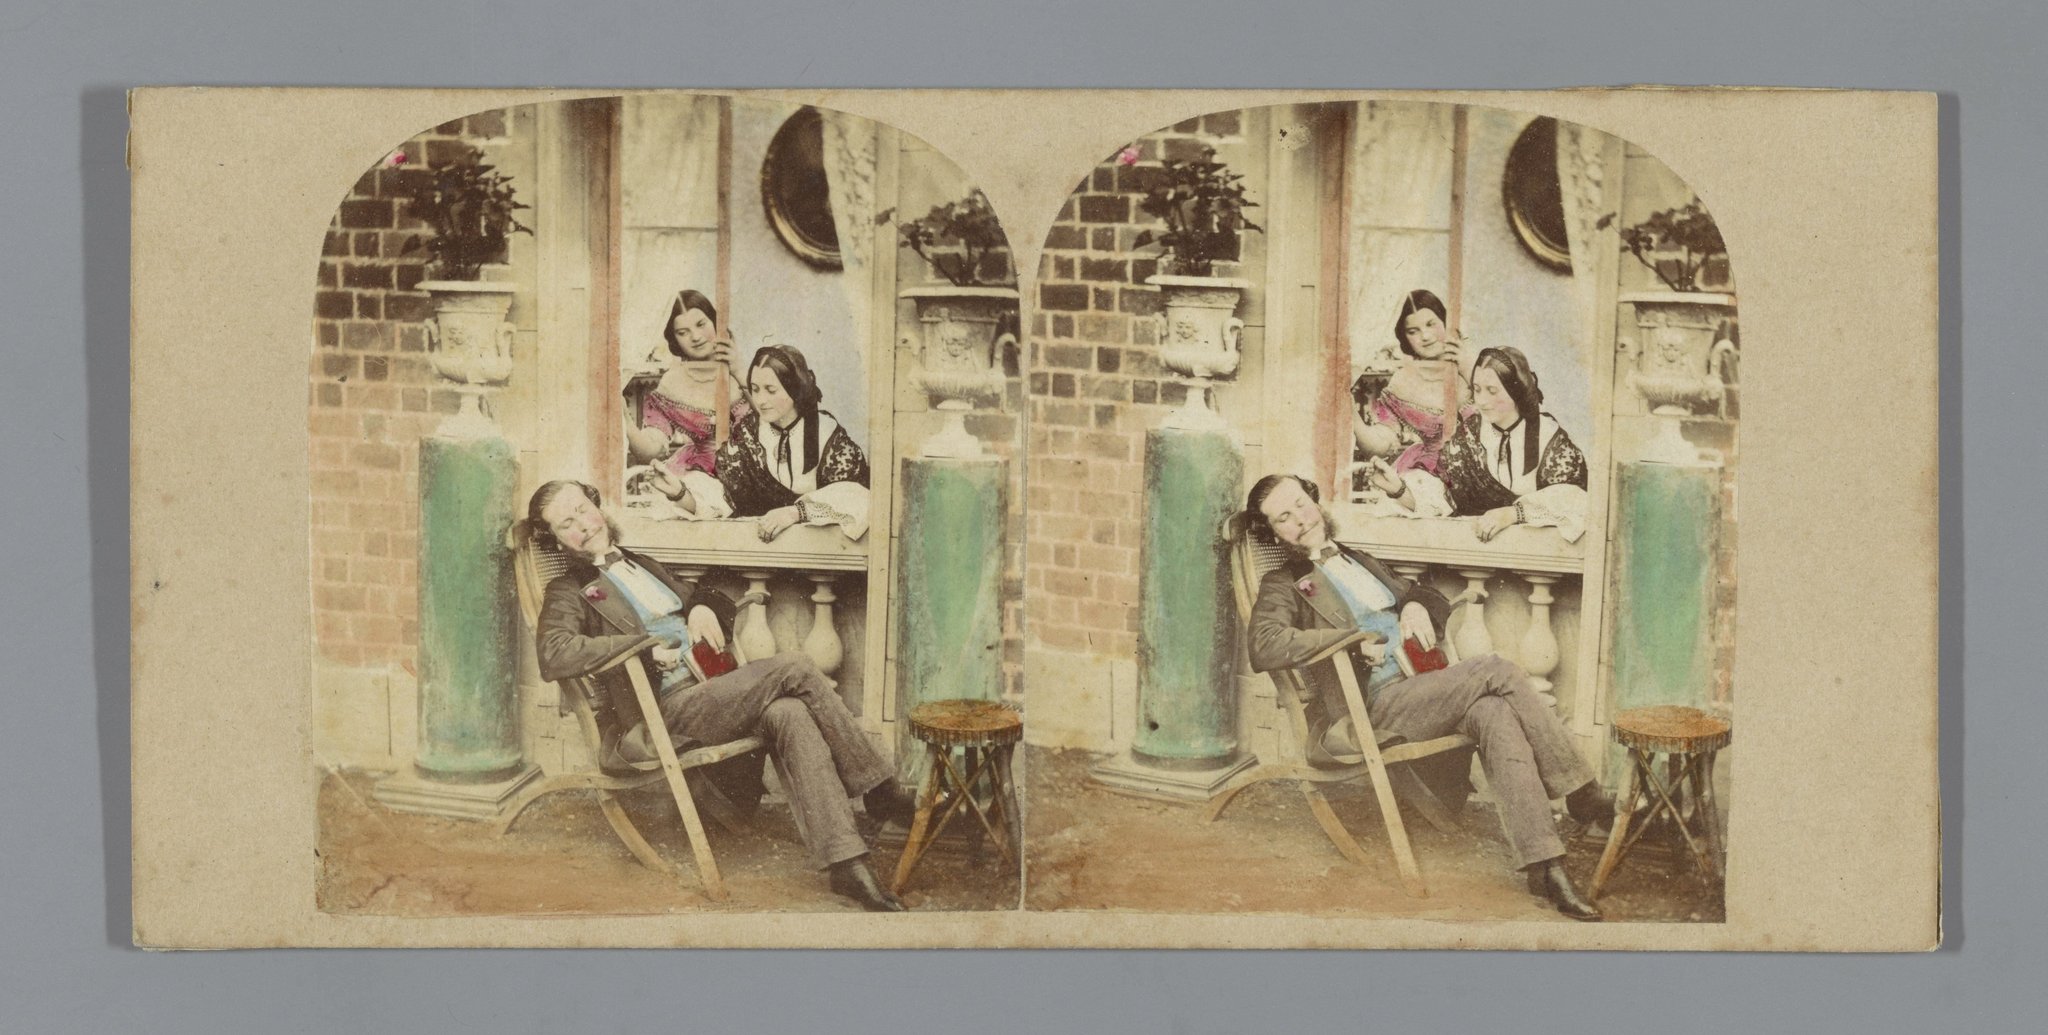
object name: stereograph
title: Twee vrouwen plagen een slapende man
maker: Anonymous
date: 1852-1863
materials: cardboard, paper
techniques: albumen print, hand coloring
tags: mocking, insulting; teasing